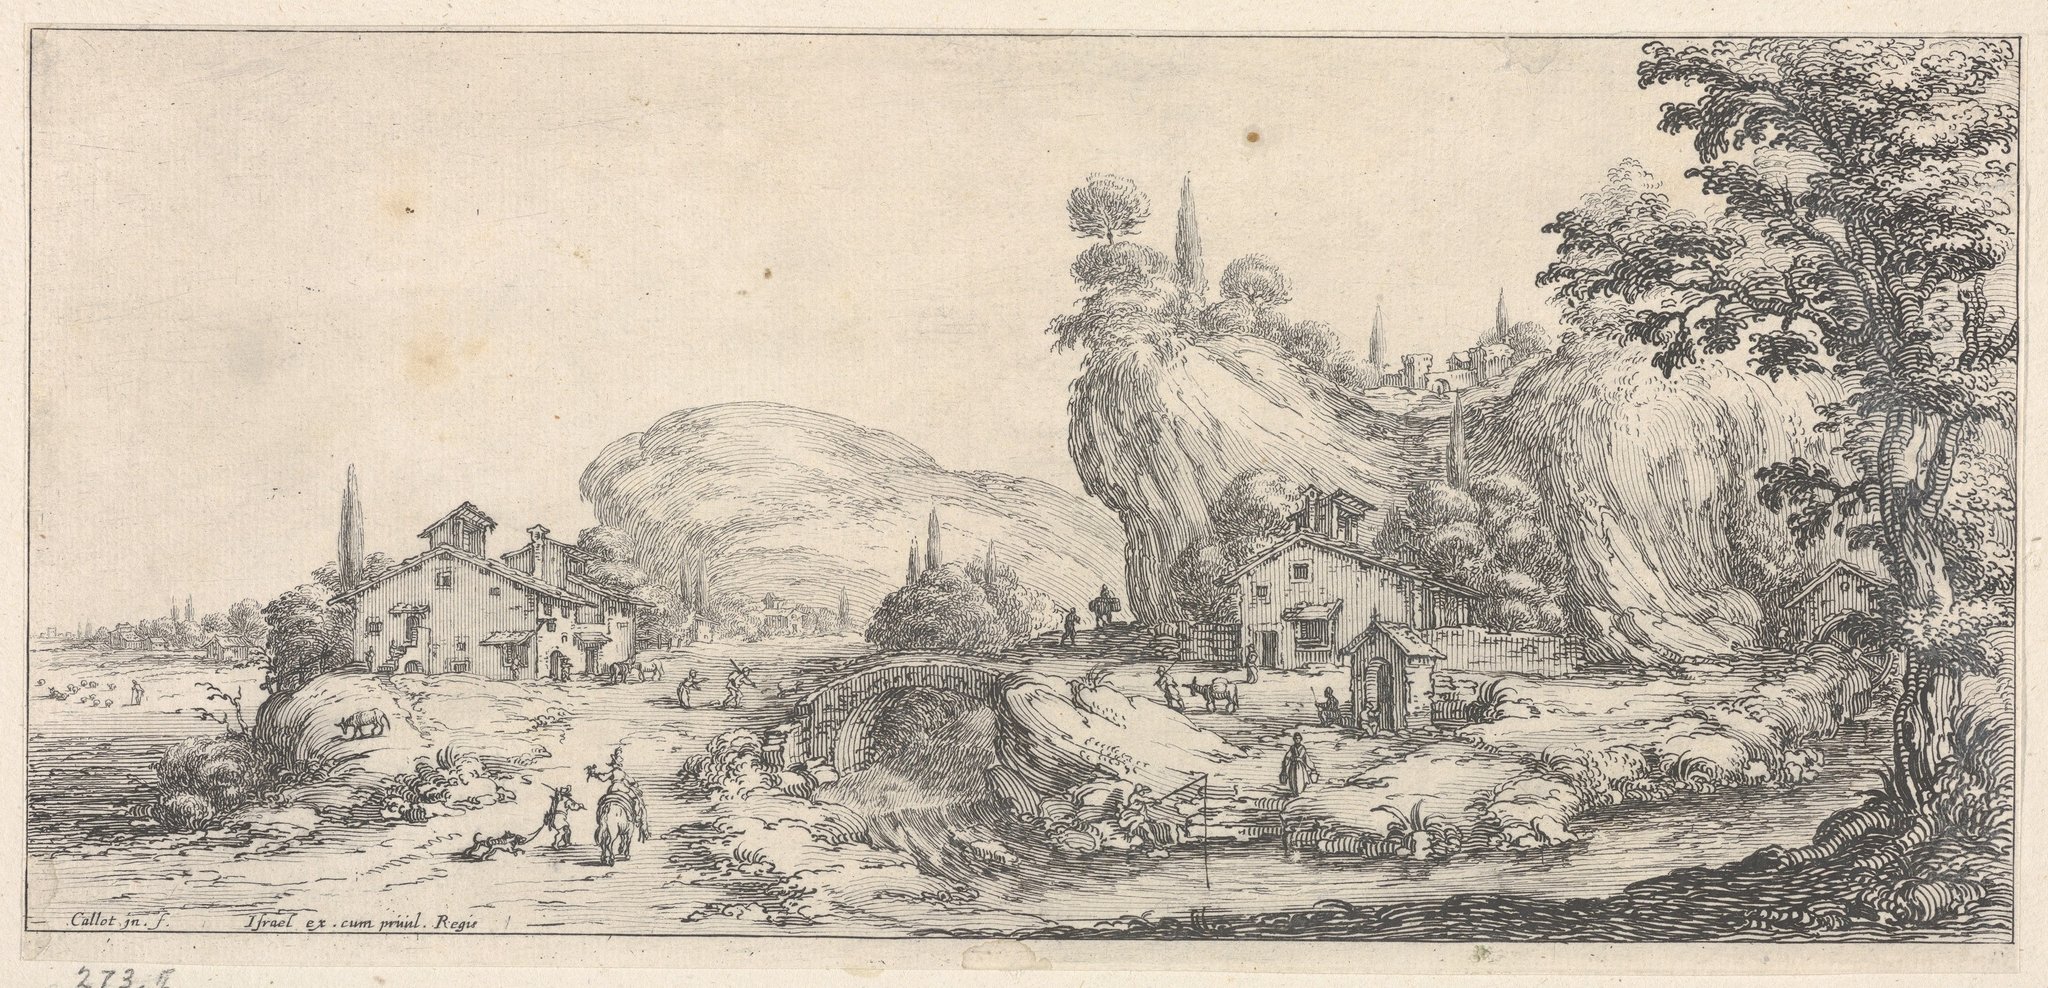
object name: print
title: Walking and mounted figures surrounding a river traversed by a bridge, with a hilly outcrop and windmill, from "Italian landscapes" (Diverse vedute designate in Fiorenza / Paysages italiens)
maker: jacques callot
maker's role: artist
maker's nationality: french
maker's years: 1592-1635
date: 1618-1635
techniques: etching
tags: rivers,landscapes